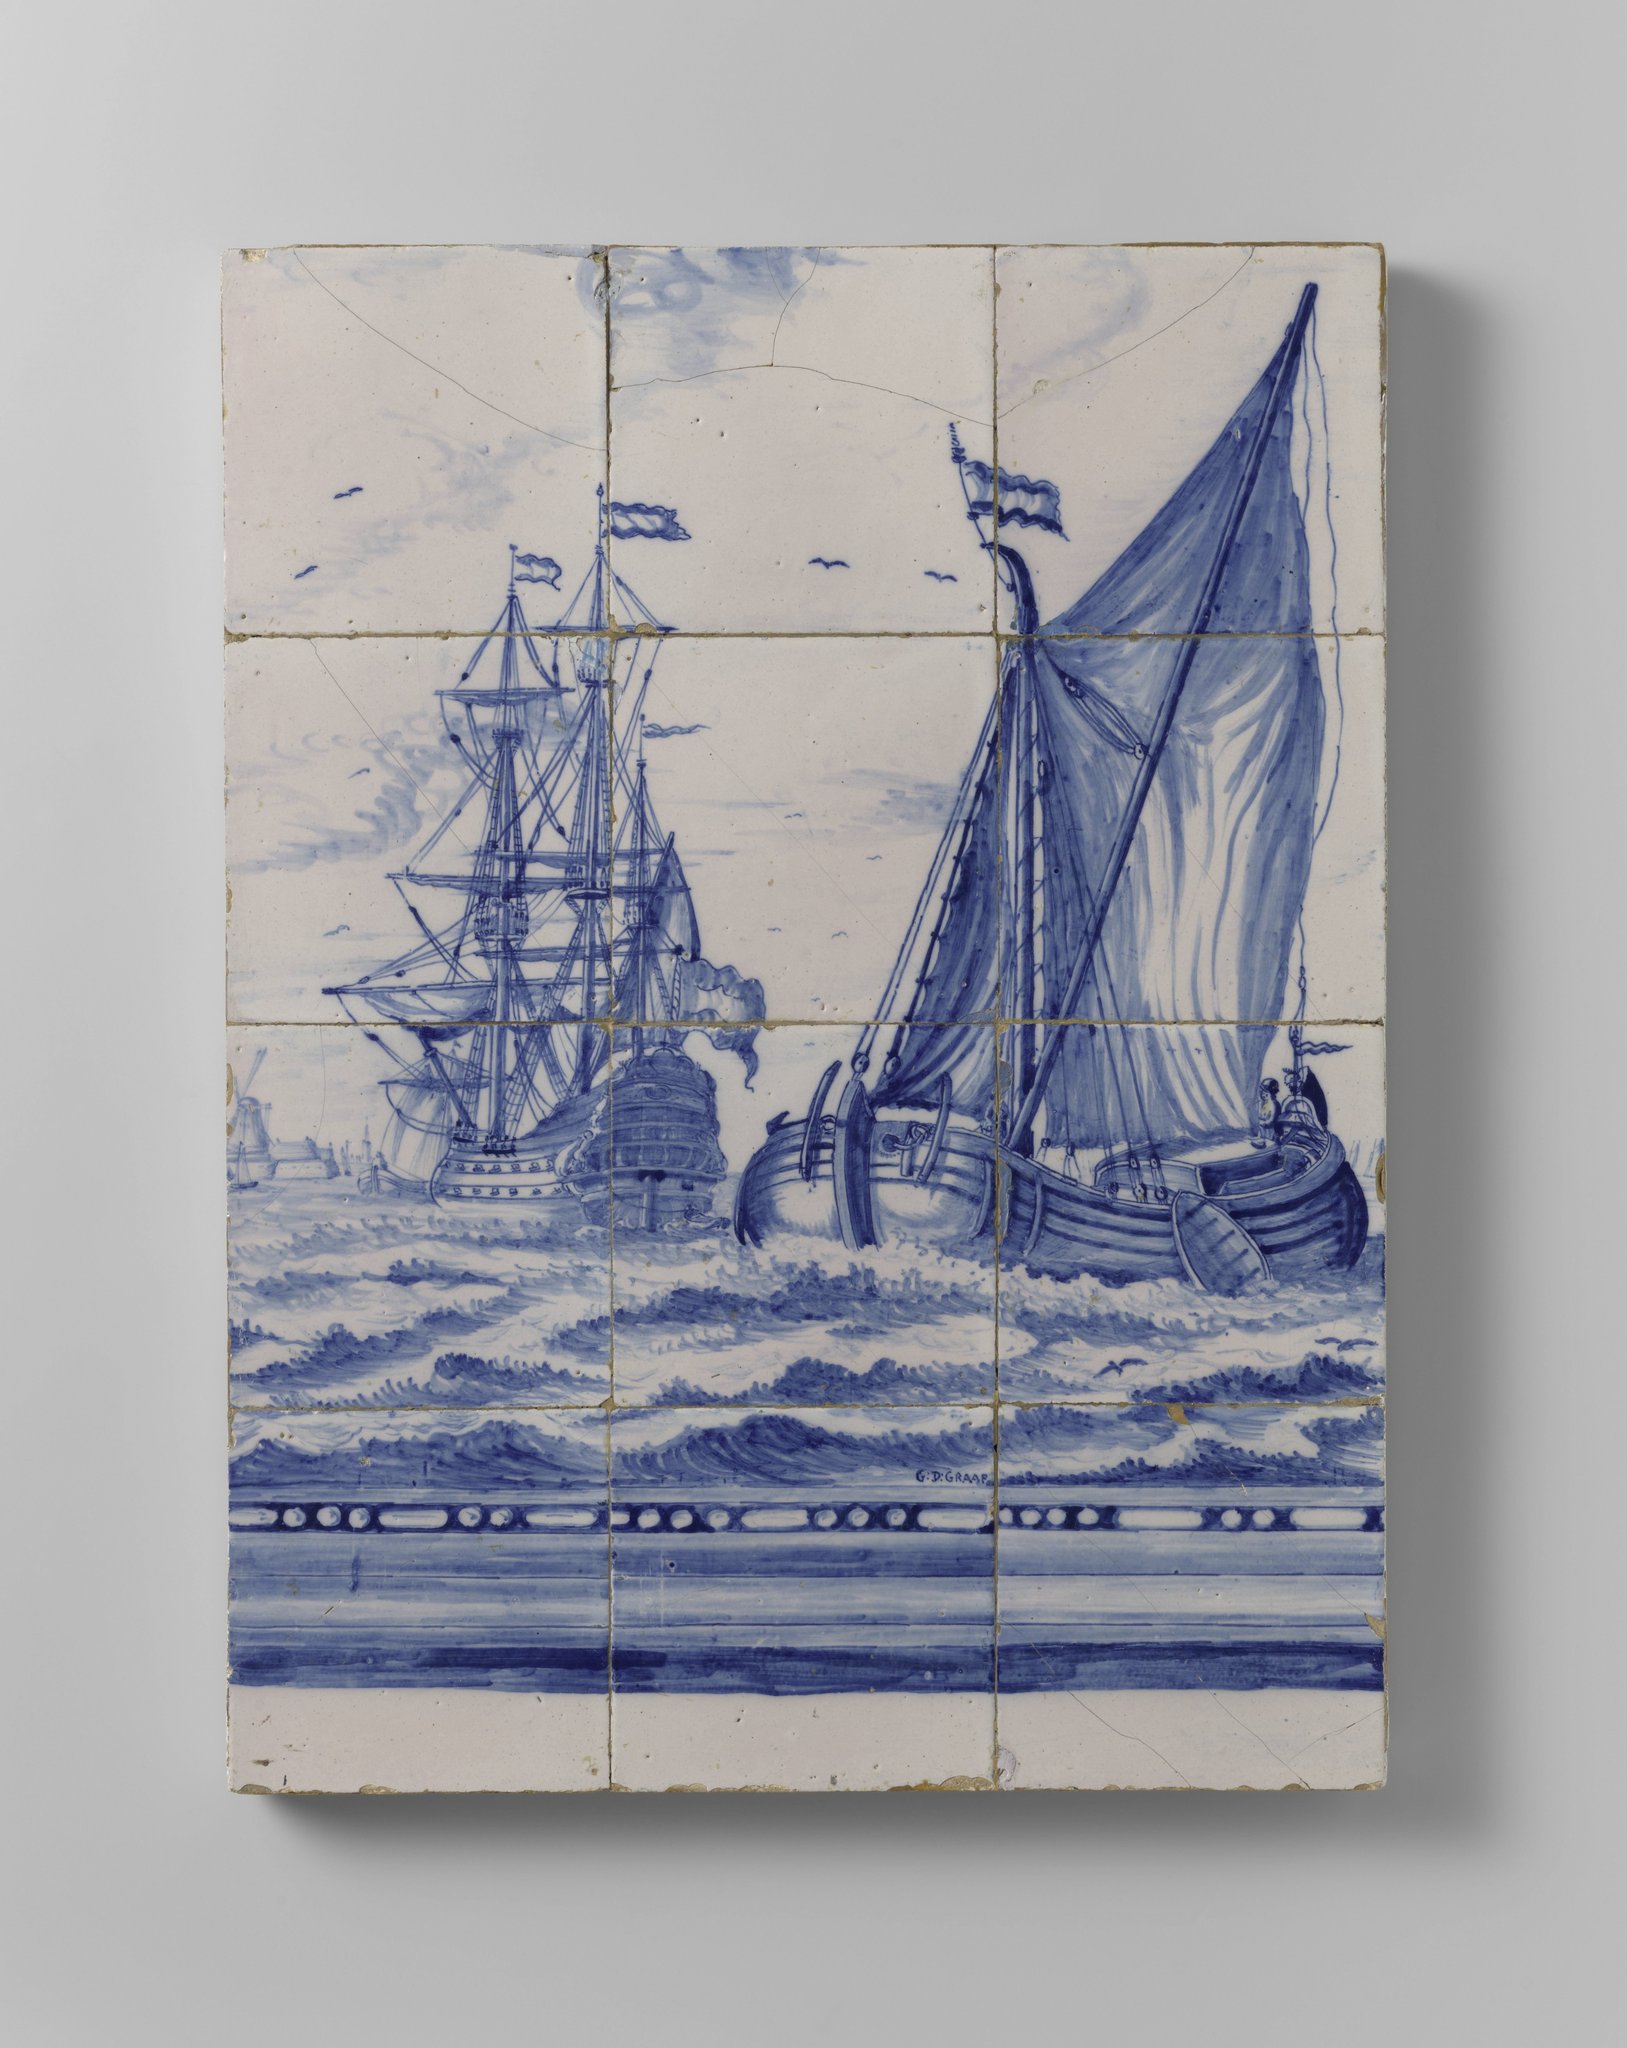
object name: tile tableau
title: Tegeltableau van twaalf tegels met bark en kofschip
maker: g. de graaf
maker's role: tegelbakker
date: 1780-1795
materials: earthenware, glaze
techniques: maiolica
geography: amsterdam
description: Tegeltableau van twaalf tegels (4 x 3) met blauw geschilderde zeilschepen: een bark en een kofschip. De onderkant is versierd met brede banden waartussen een parellijst. Onderaan gesigneerd: G:D: GRAAF.